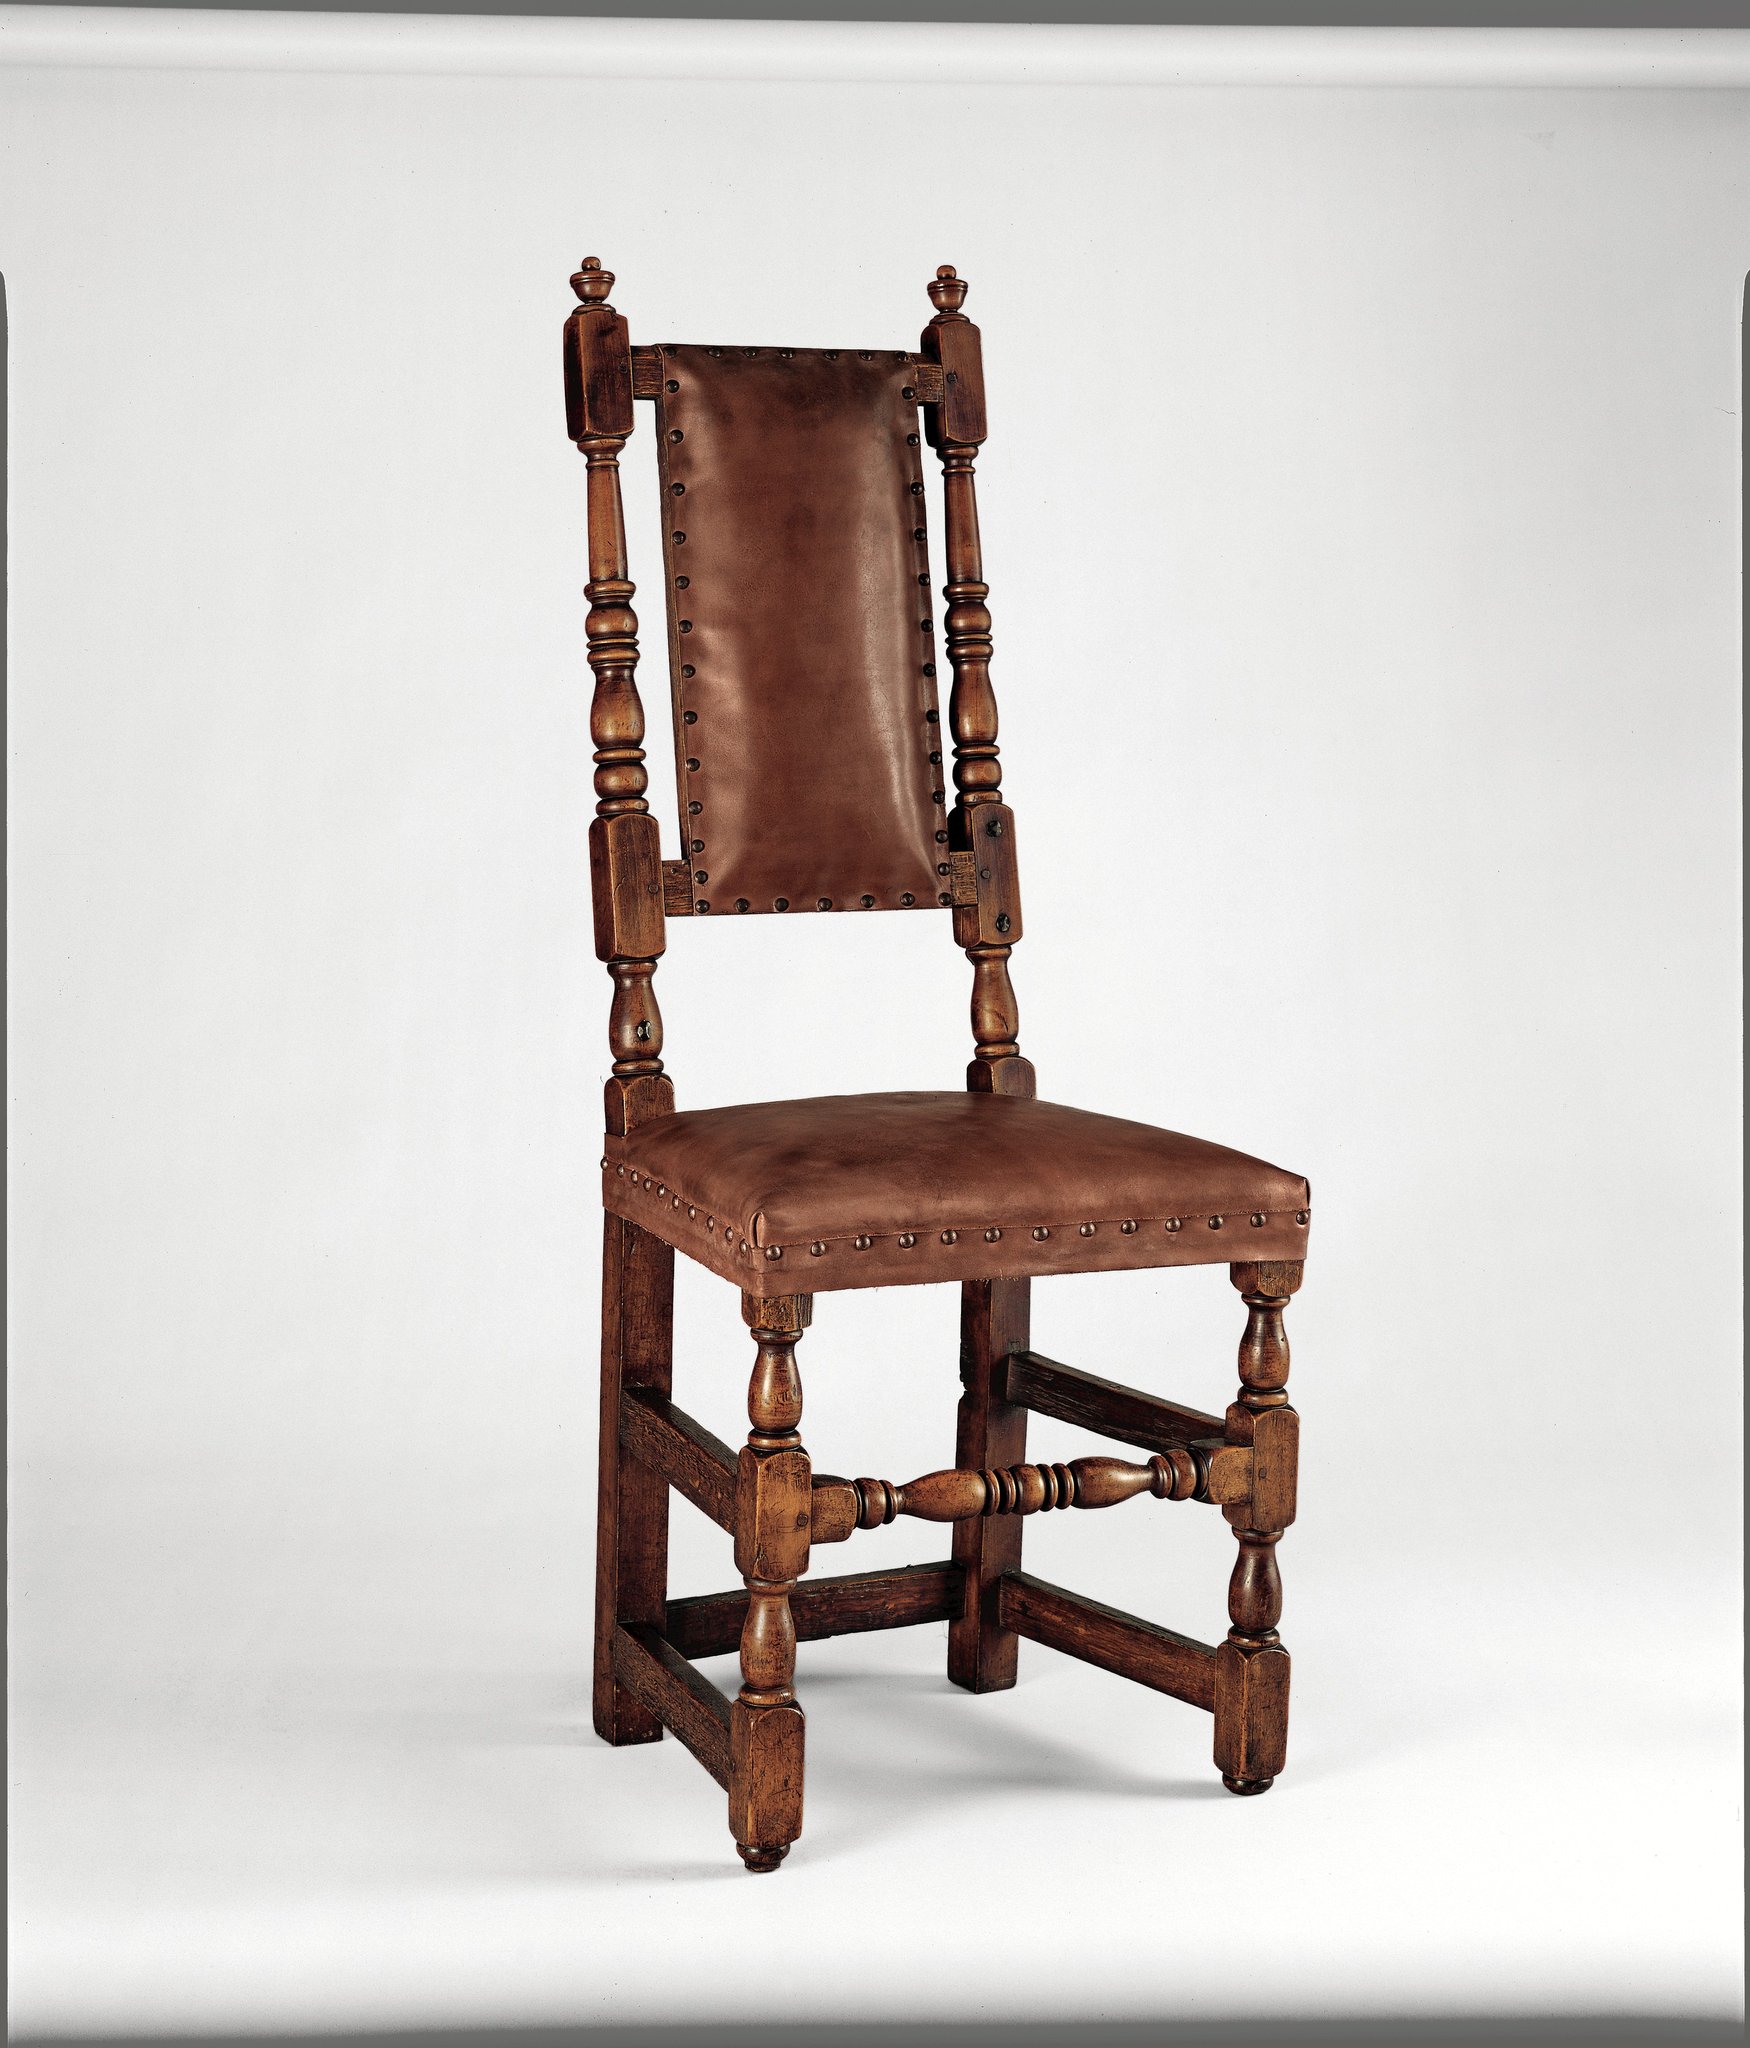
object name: side chair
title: Leather chair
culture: american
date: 1695-1715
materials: wood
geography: united states